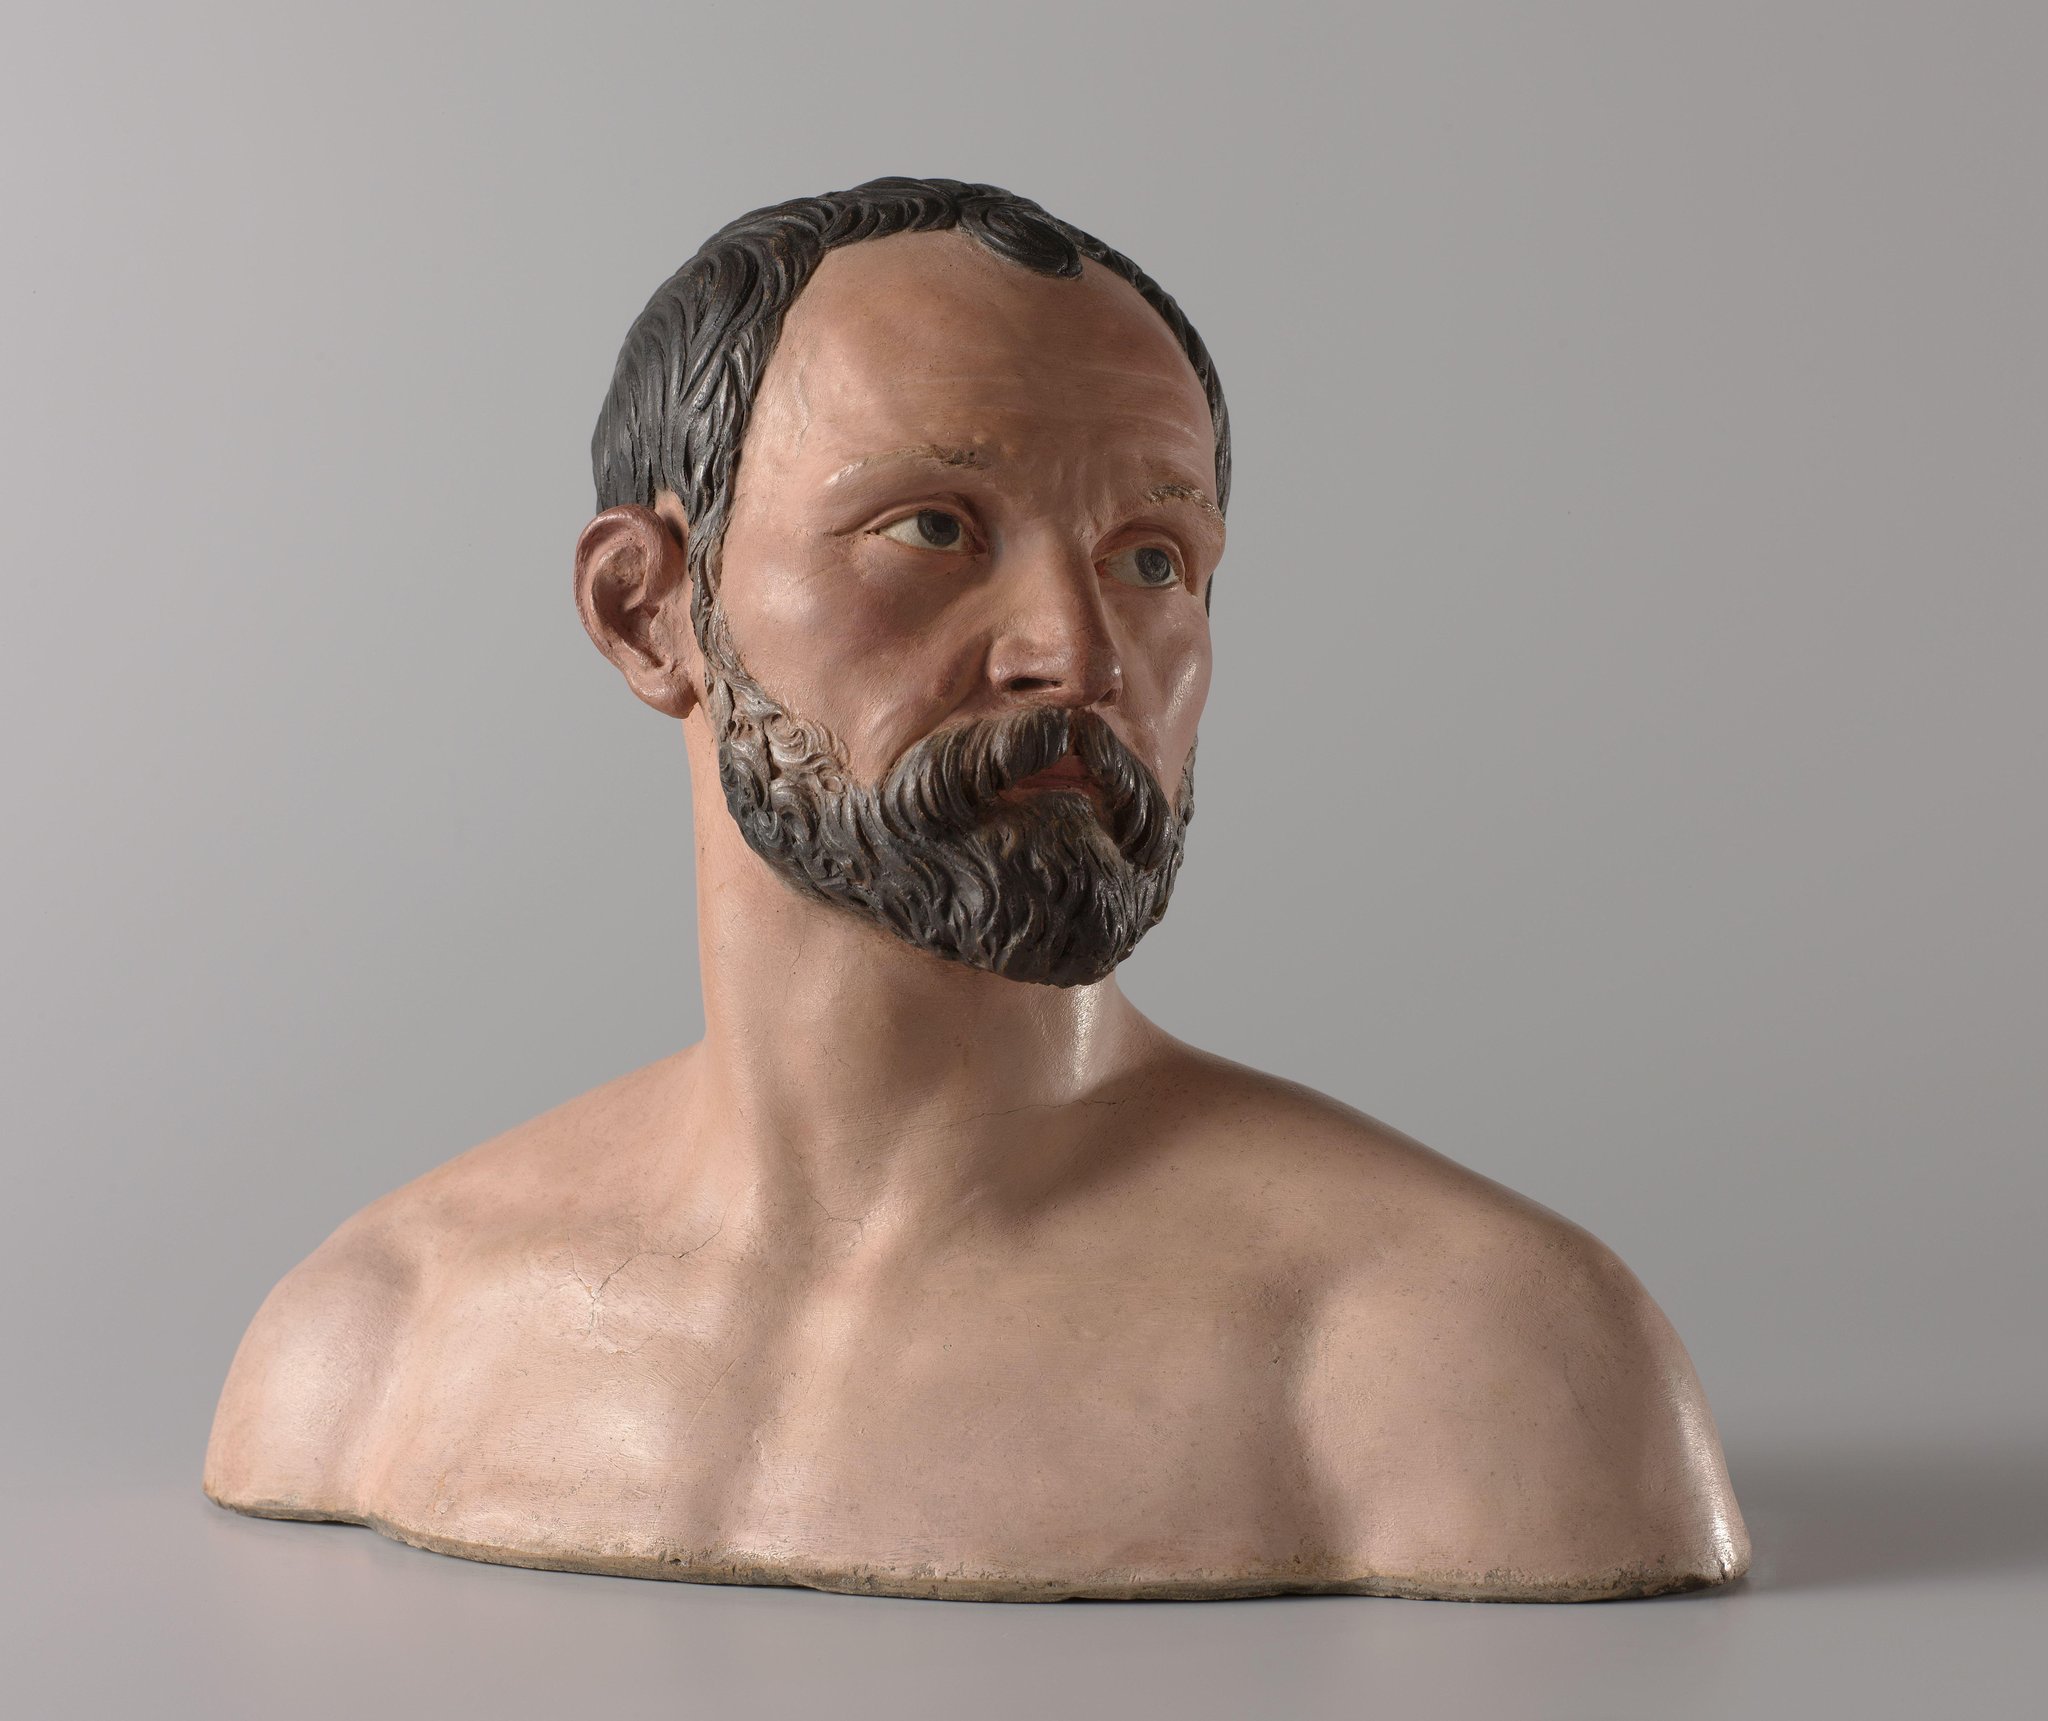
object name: bust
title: Self-portrait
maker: johan gregor van der schardt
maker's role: sculptor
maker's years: 1530-1581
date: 1573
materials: oil, terracotta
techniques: firing, modeling, painted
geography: nuremberg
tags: nijmegen, sculptor, johan gregor van der schardt, portrait, self-portrait of sculptor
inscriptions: inscription, on a label on the reverse, handwritten: ‘Jean de Bologne collection de Paul de Praun’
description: To make this small bust – it is half life-size – the sculptor had to resort to all kinds of tricks with a mirror. Van der Schardt did not portray himself frontally, but with his head turned sideways, as if to avoid looking at the viewer. The nude upper torso alludes to sculpture from Classical antiquity.